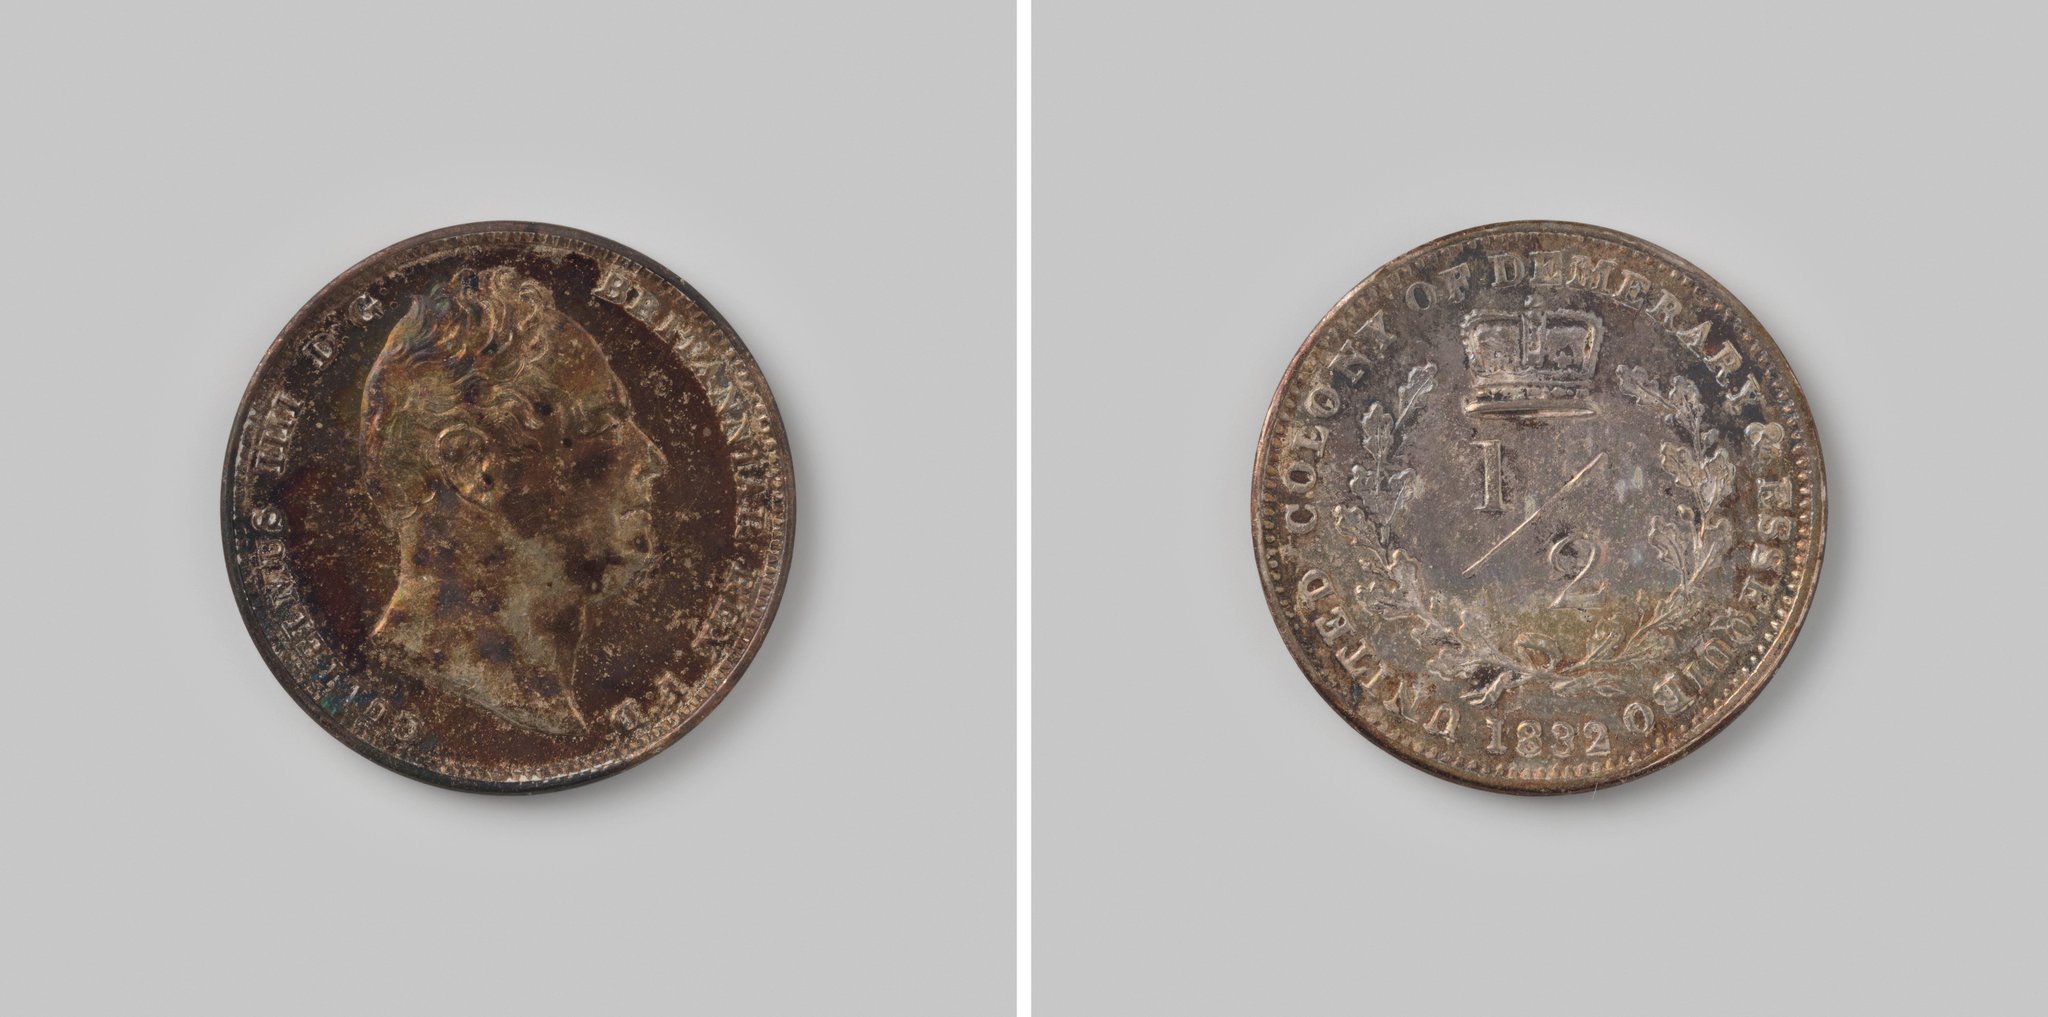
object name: coin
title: Essequibo & Demarary, koning William IV, ½ guilder, 1832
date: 1832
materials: silver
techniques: striking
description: Zilveren munt. Voorzijde: hoofd van de koning naar rechts. Keerzijde: tussen twee samengebonden takken waarde-aanduiding: ½, waarboven kroon. Jaartal onderaan in omschrift. Gladde rand.